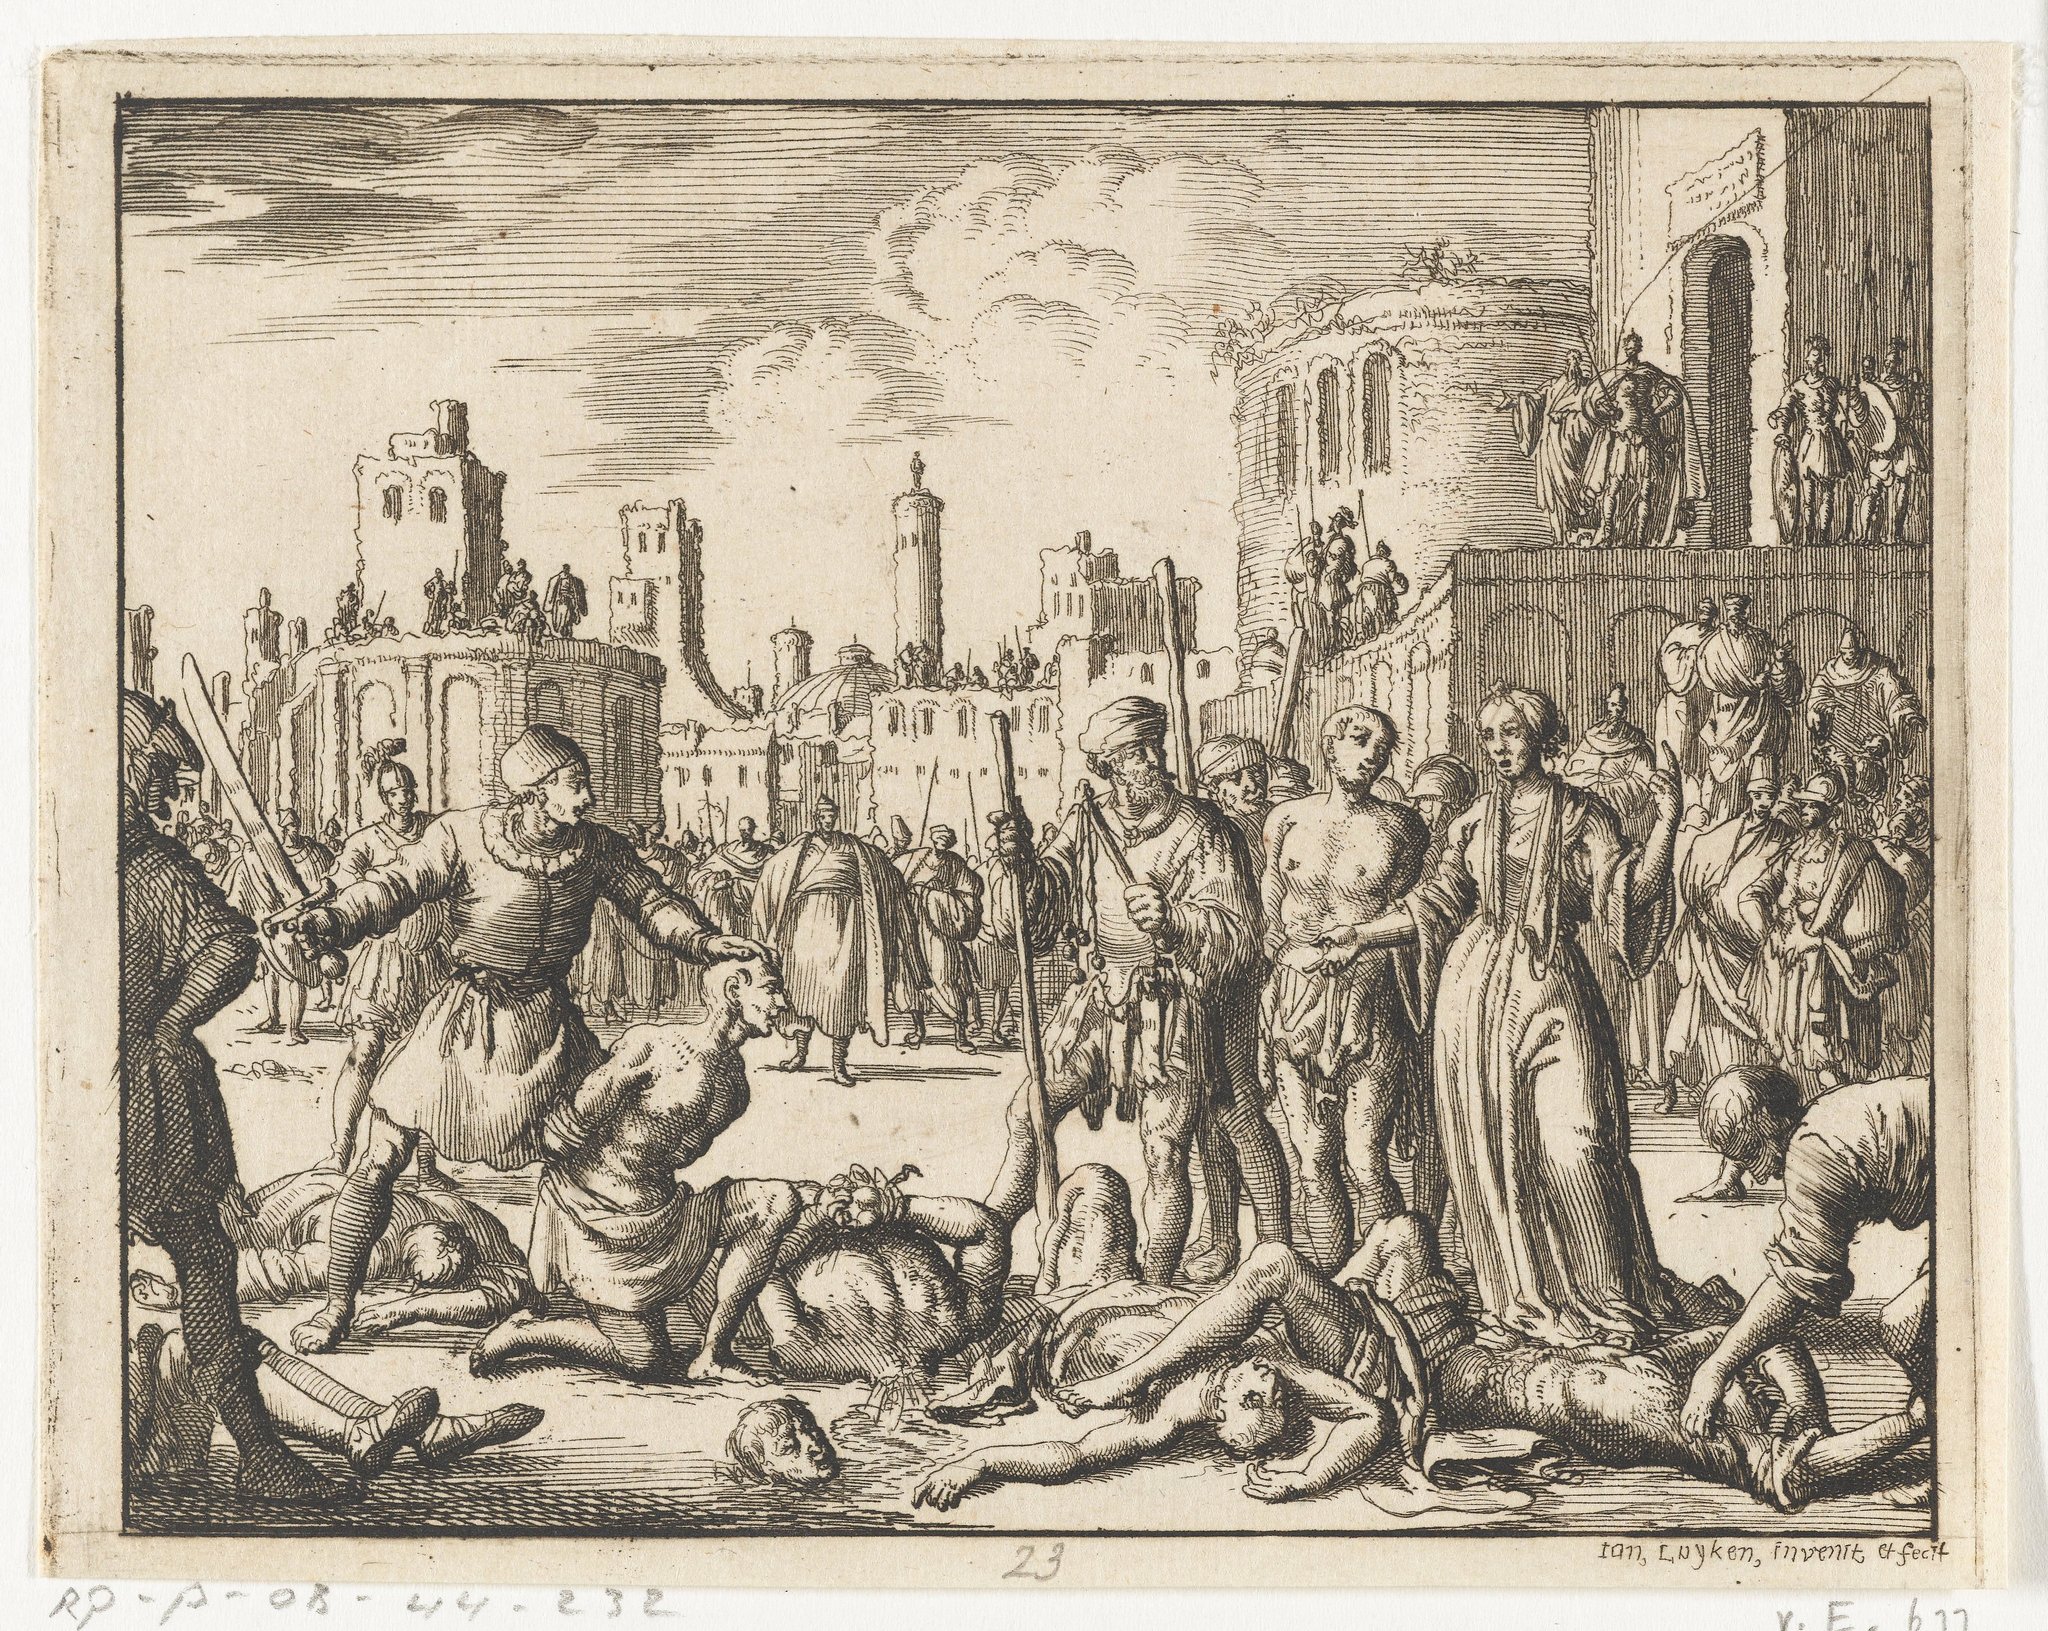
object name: print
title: Felicitas met haar zeven zonen onthoofd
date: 1685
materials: paper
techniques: etching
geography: amsterdam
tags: female saints (with name) - death, deathbed of female saint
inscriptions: collector's mark: Lugt 2228, number: ‘23’